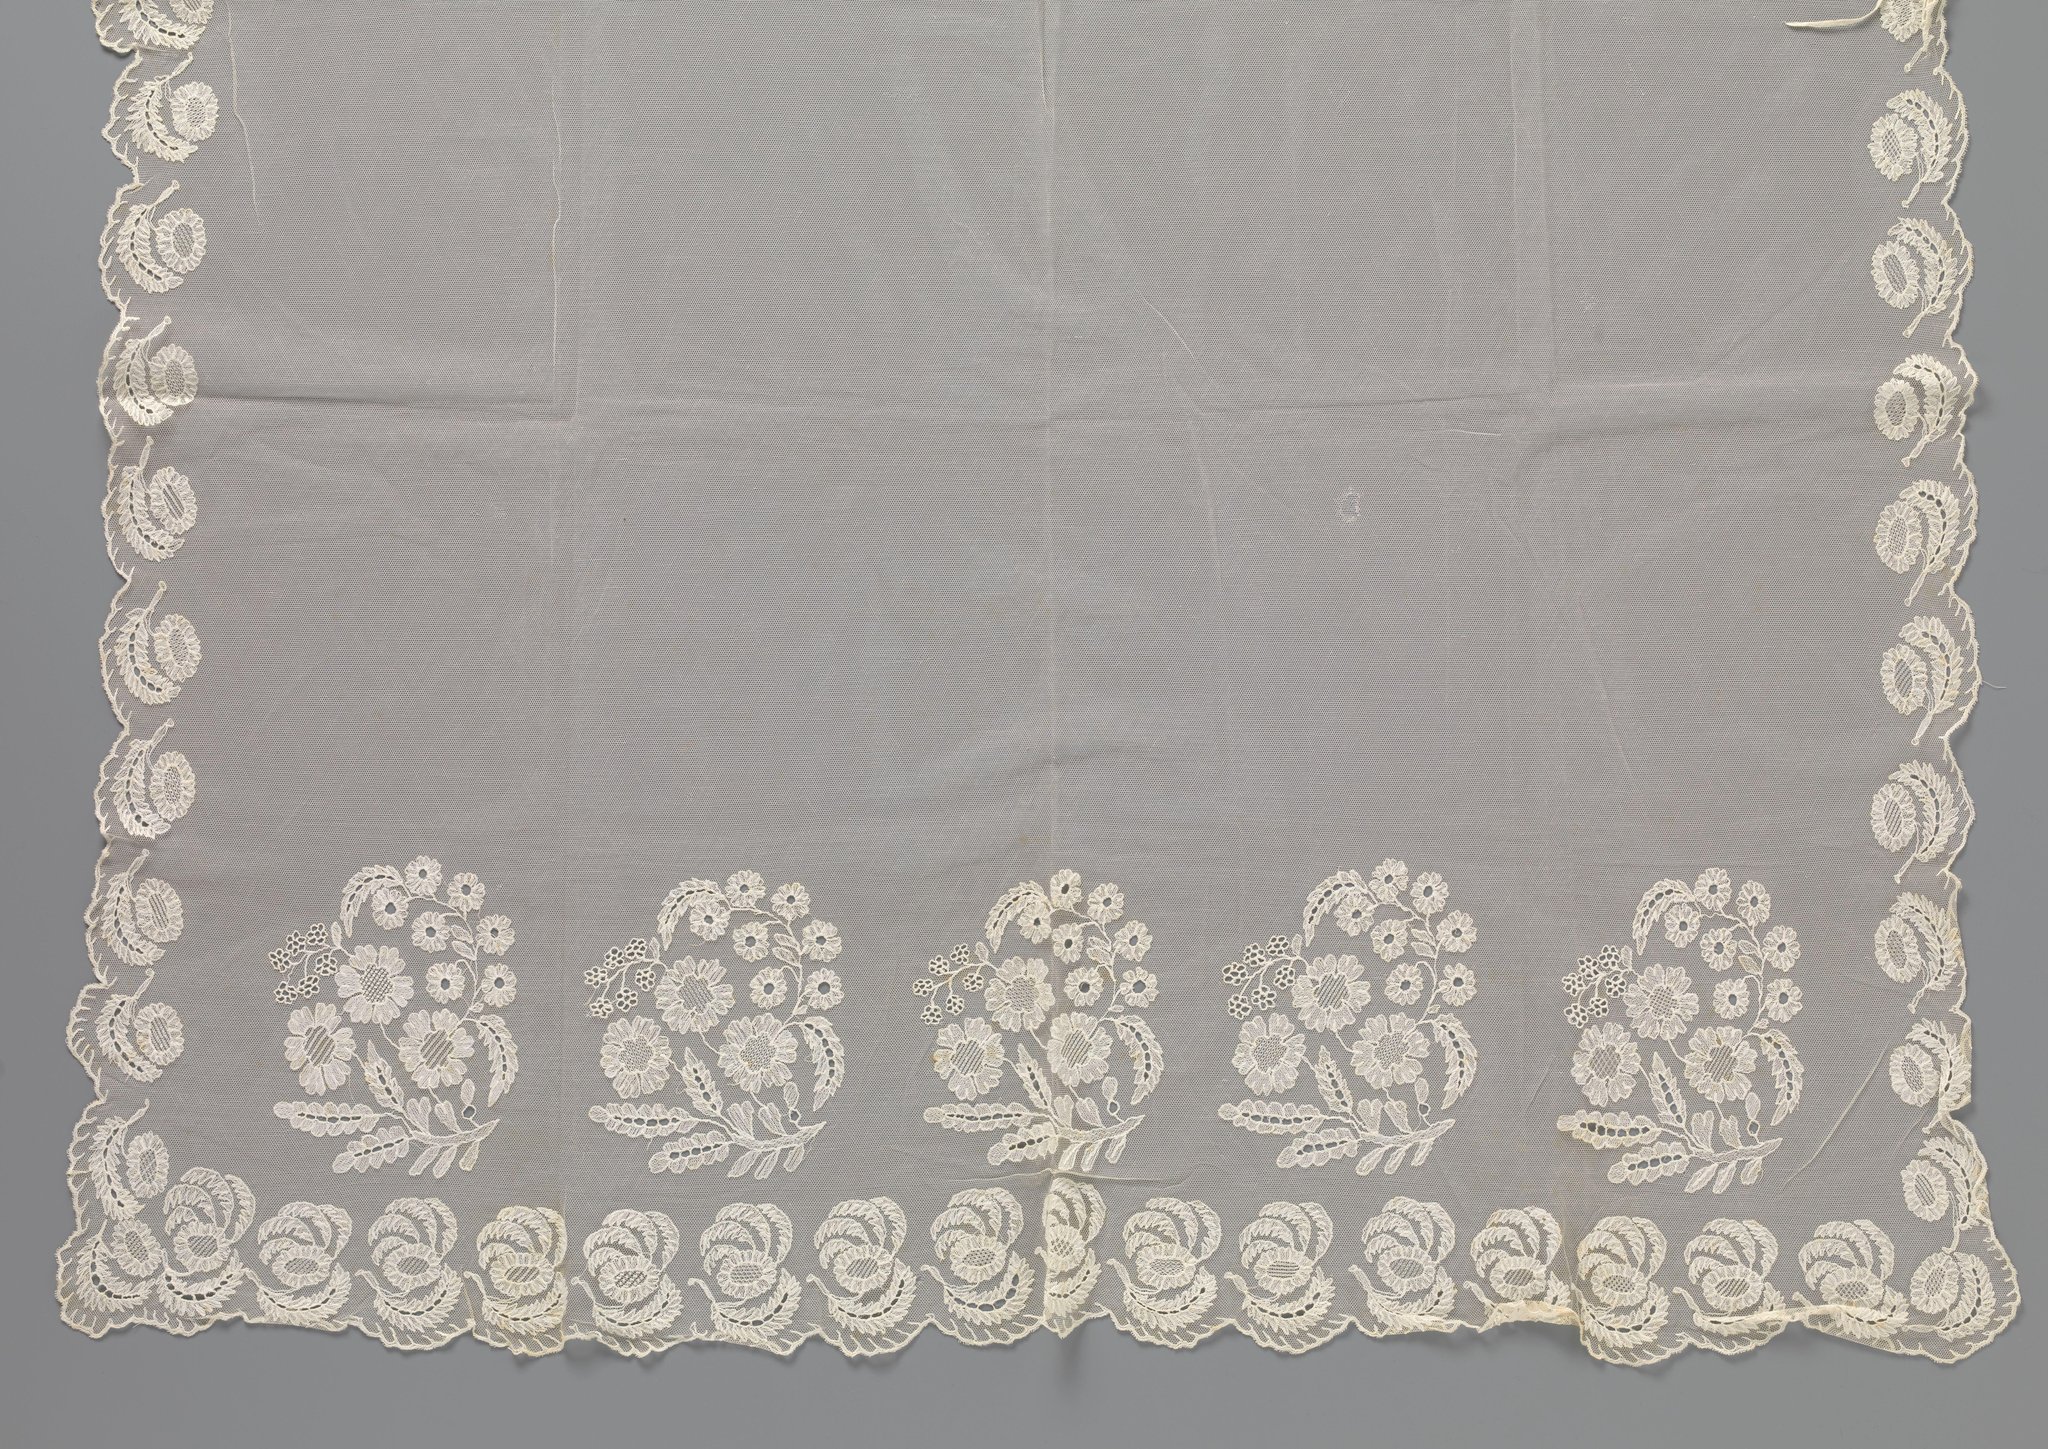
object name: streekdracht, streekkleding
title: Schort van tuledoorstopwerk op machinale tule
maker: Anonymous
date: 1830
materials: linen, fiber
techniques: lace embroidery, tulle darning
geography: friesland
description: Schort van naturelkleurig kantborduurwerk: tuledoorstopwerk op machinale tule. Rechthoekig model, met schulpenranden langs de lange zijden en de onderzijde. Langs de rechte bovenzijde is een zoompje in de tule gemaakt, waar een lintje doorheen is geregen. Het patroon bestaat boven elke schulp uit een liggend gevederd blad waarboven een margriet bekroond door vier gebogen gevederde bladeren. Langs de benedenrand staat boven dit randpatroon nog een rij met vijf dezelfde grote bloemtakken met onder andere drie margrieten en vergeet-mij-nietjes.